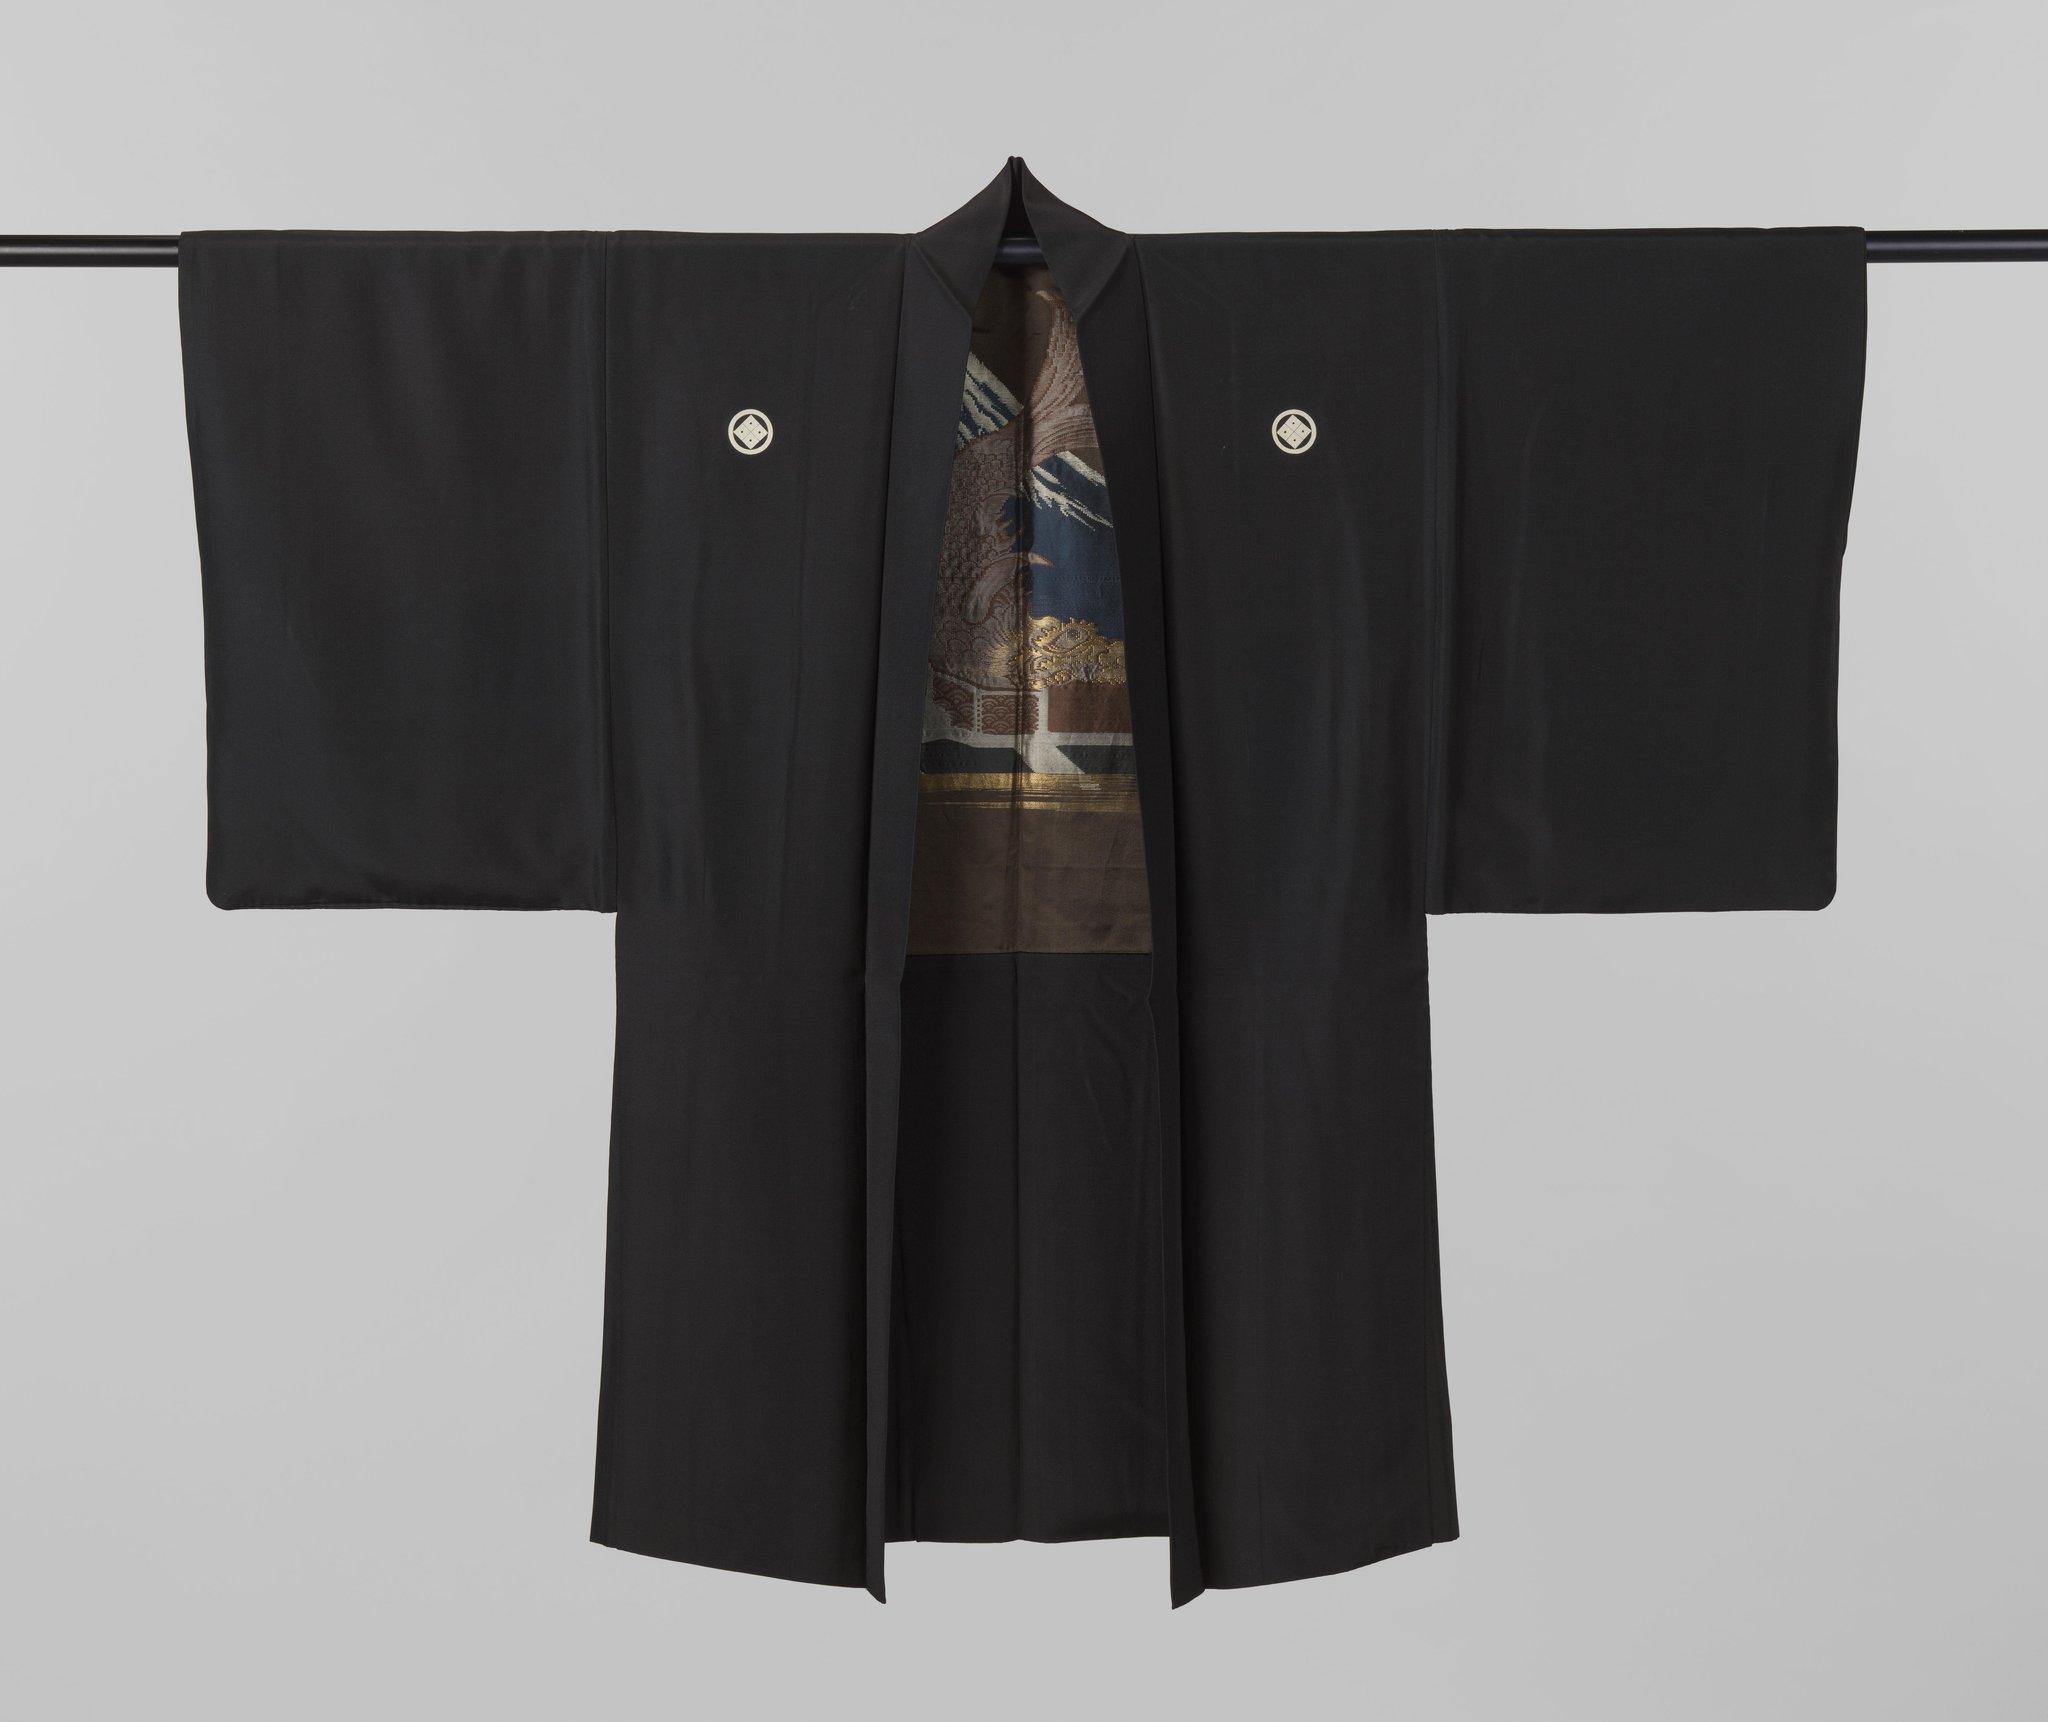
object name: kimono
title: Mannen haori met dakornament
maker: Anonymous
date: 1920-1940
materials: silk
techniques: weave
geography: japan